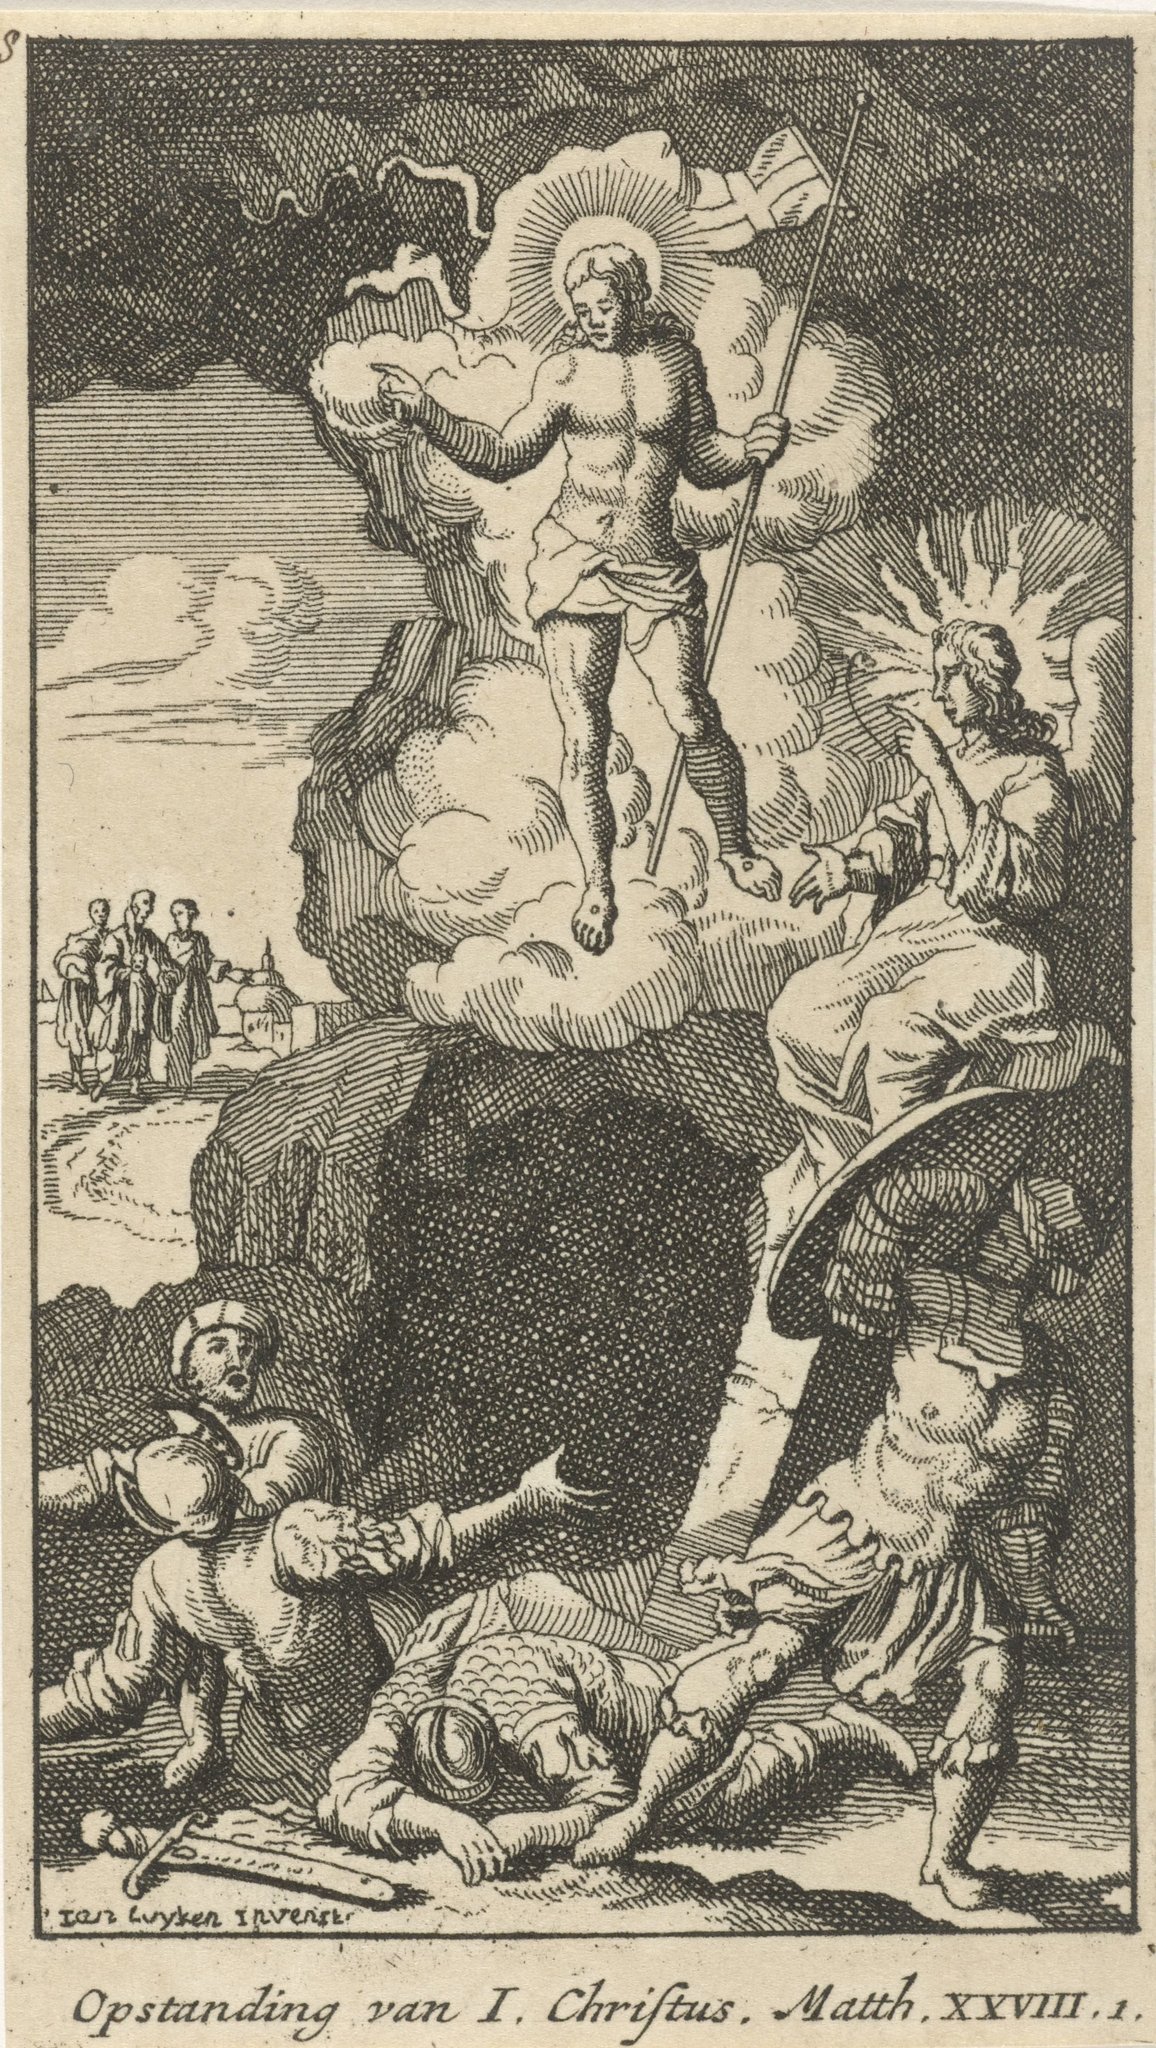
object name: print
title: Vierentwintig scènes uit het Nieuwe Testament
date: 1720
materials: paper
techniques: etching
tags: christ, usually holding a banner, arises from the grave; often combined with sleeping and/or frightened soldiers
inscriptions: number: ‘9’, collector's mark: Lugt 2228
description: Prent opgenomen in: Het Nieuw Testament onzes Heere Jesus Christus. Amsterdam: Wed. Albert Klumper en Jan Kalverum, 1720. In dit boek is de gehele serie met 24 scènes uit het Nieuwe Testament naar Jan Luyken opgenomen. De originele prent door J. Luyken verscheen mogelijk voor het eerst in: Het Nieuwe Testament ofte alle Boecken des Nieuwen Verbondts onses Heeren Iesu Christi. Amsterdam: Hieronymus Sweerts, Jan ten Hoorn, Jan Bouman en Daniel van den Dalen, 1681.